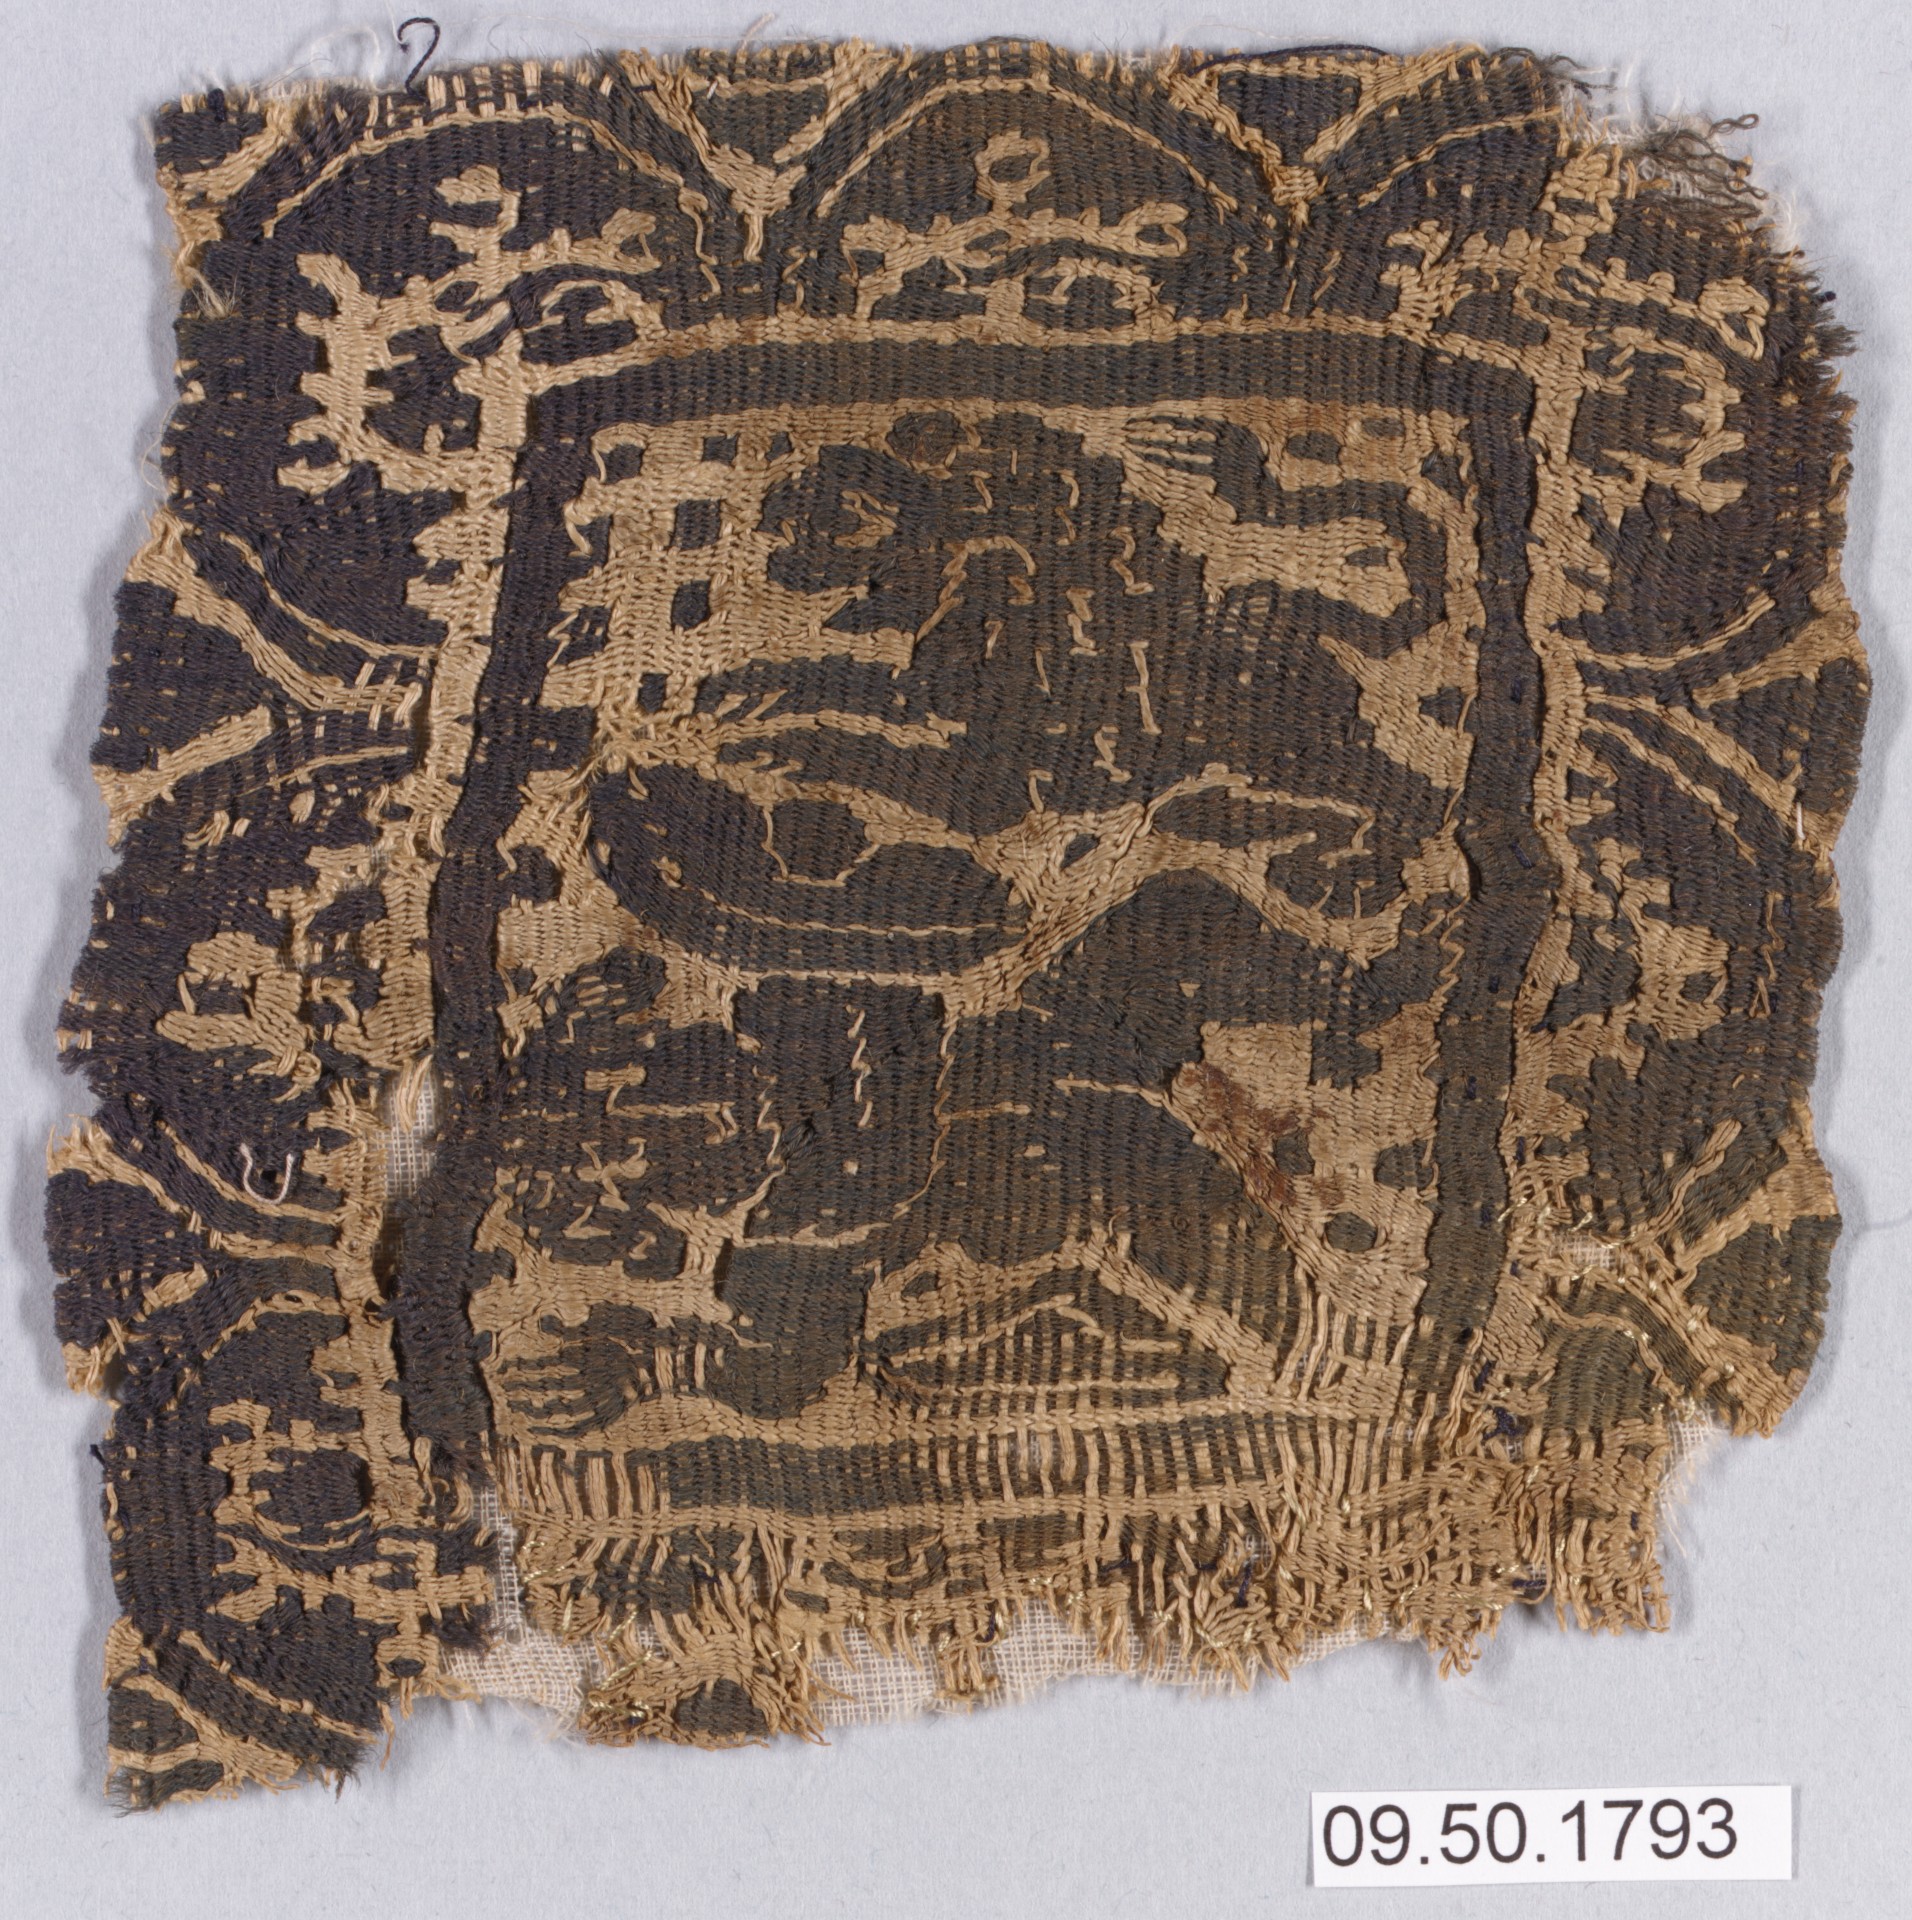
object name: square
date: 301-400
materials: linen, wool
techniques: weave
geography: egypt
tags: lions